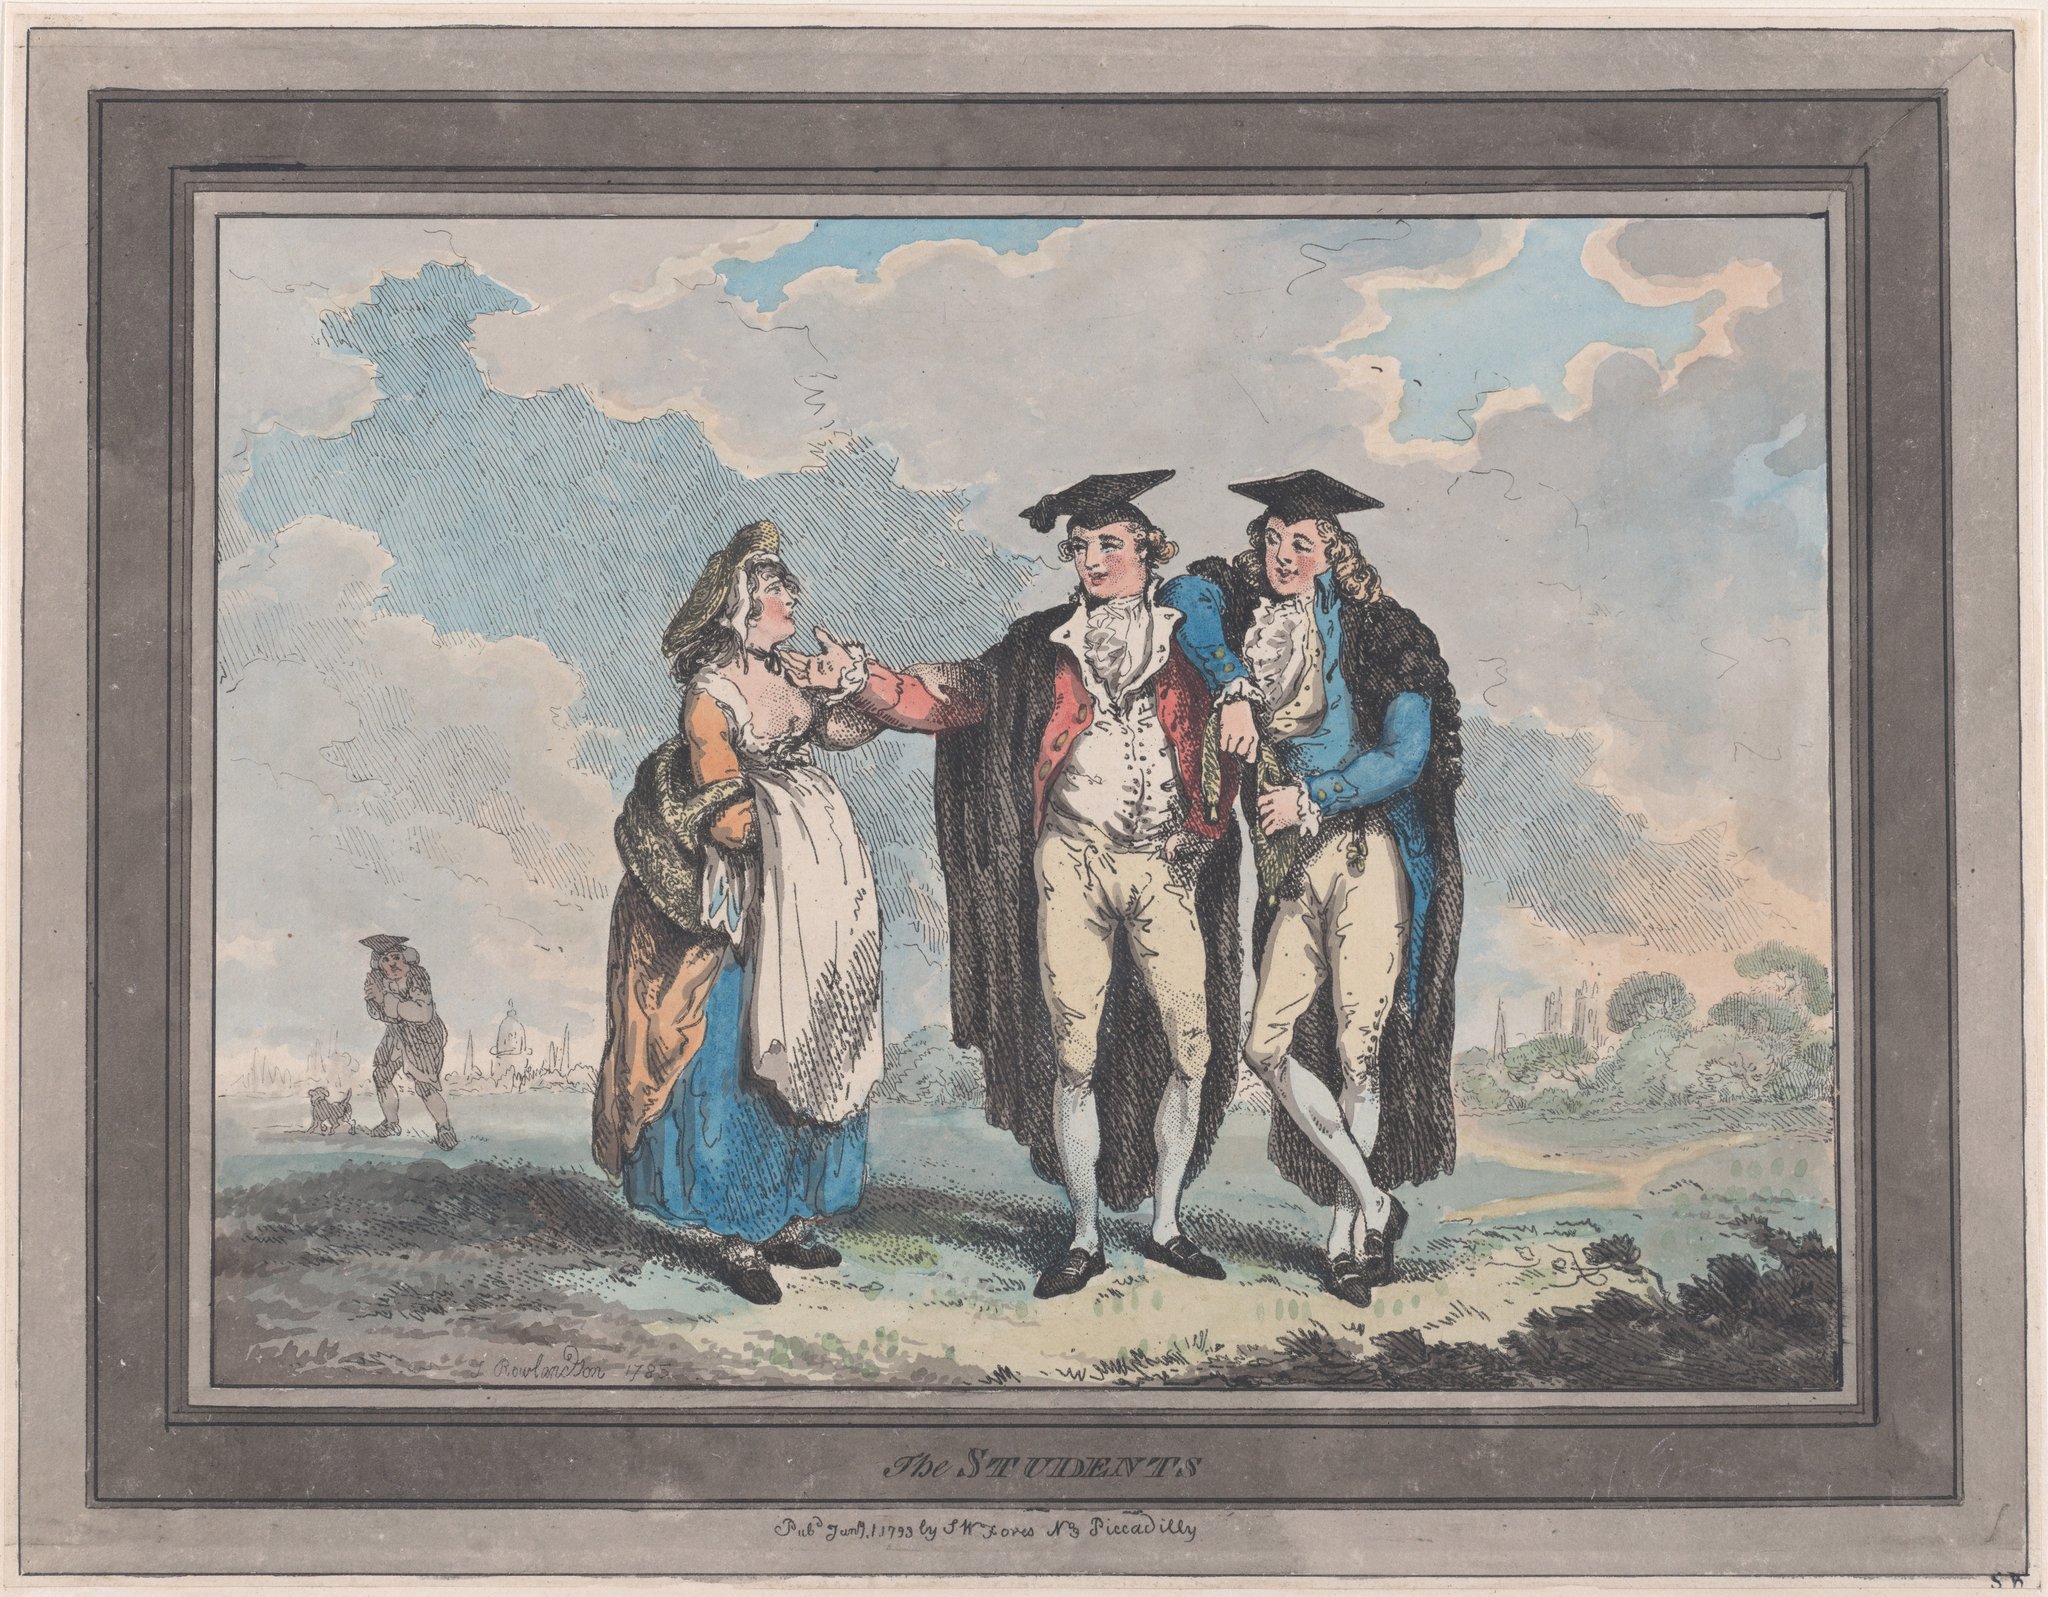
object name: print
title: The Students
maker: thomas rowlandson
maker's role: artist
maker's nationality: british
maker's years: 1757-1827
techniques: etching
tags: men,women,students